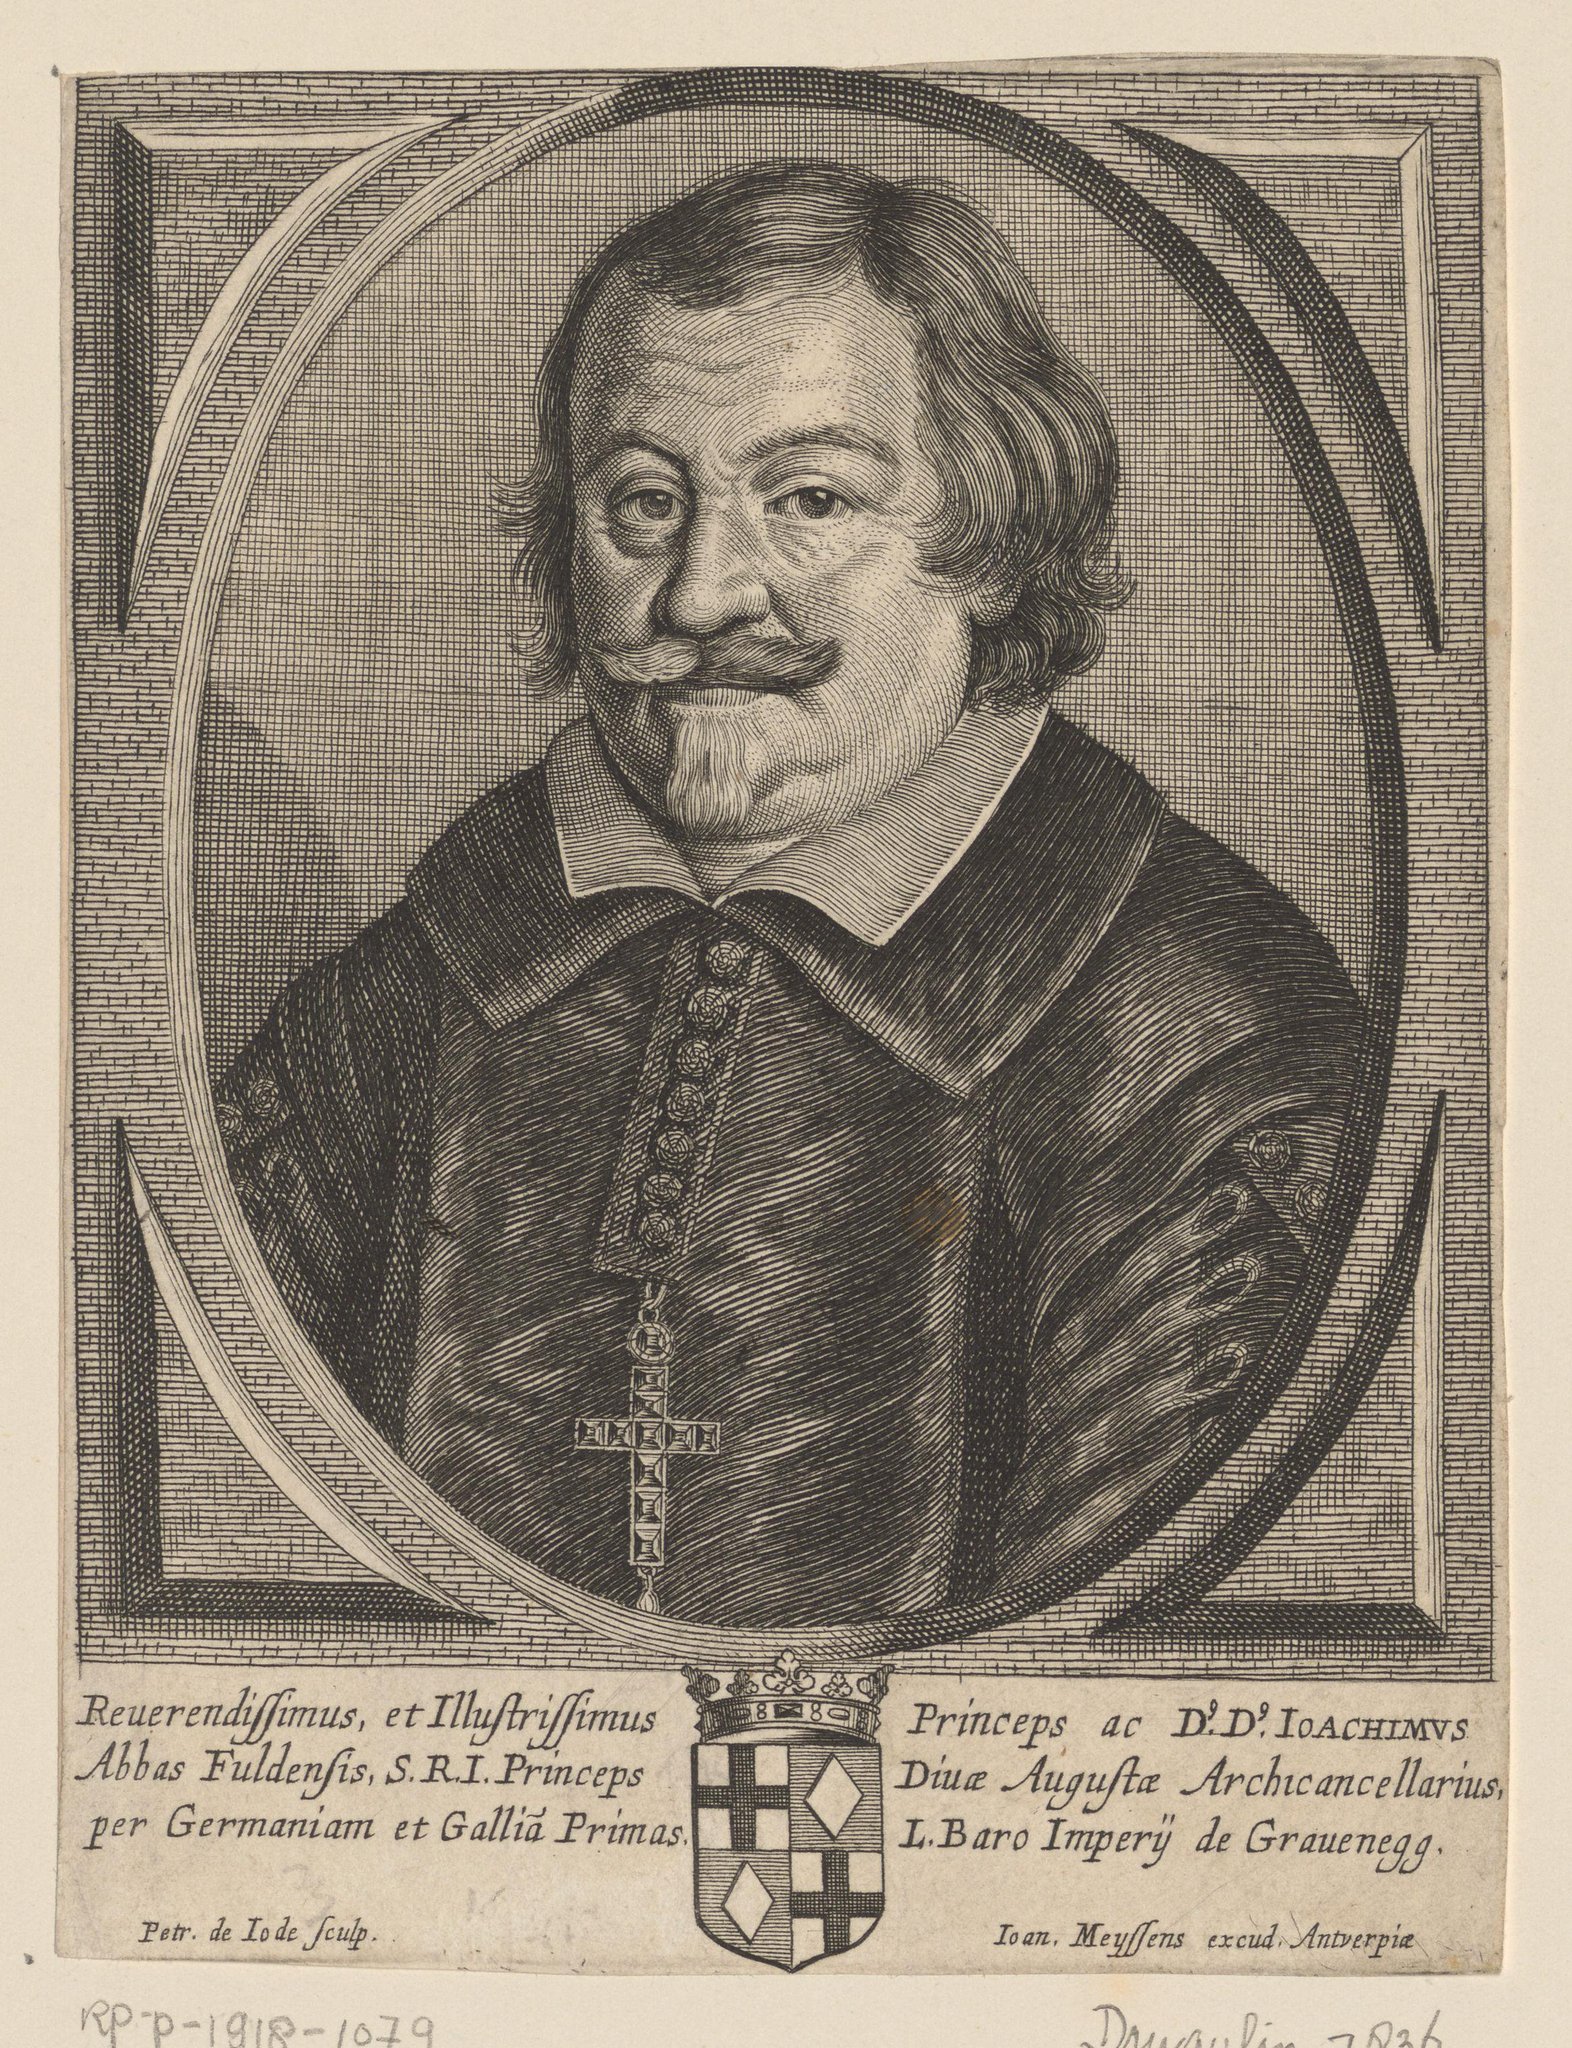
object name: print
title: Portret van Joachim von Gravenegg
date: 1640-1670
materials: paper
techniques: engraving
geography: antwerp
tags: theologian, historical persons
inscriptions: collector's mark: Lugt 2233